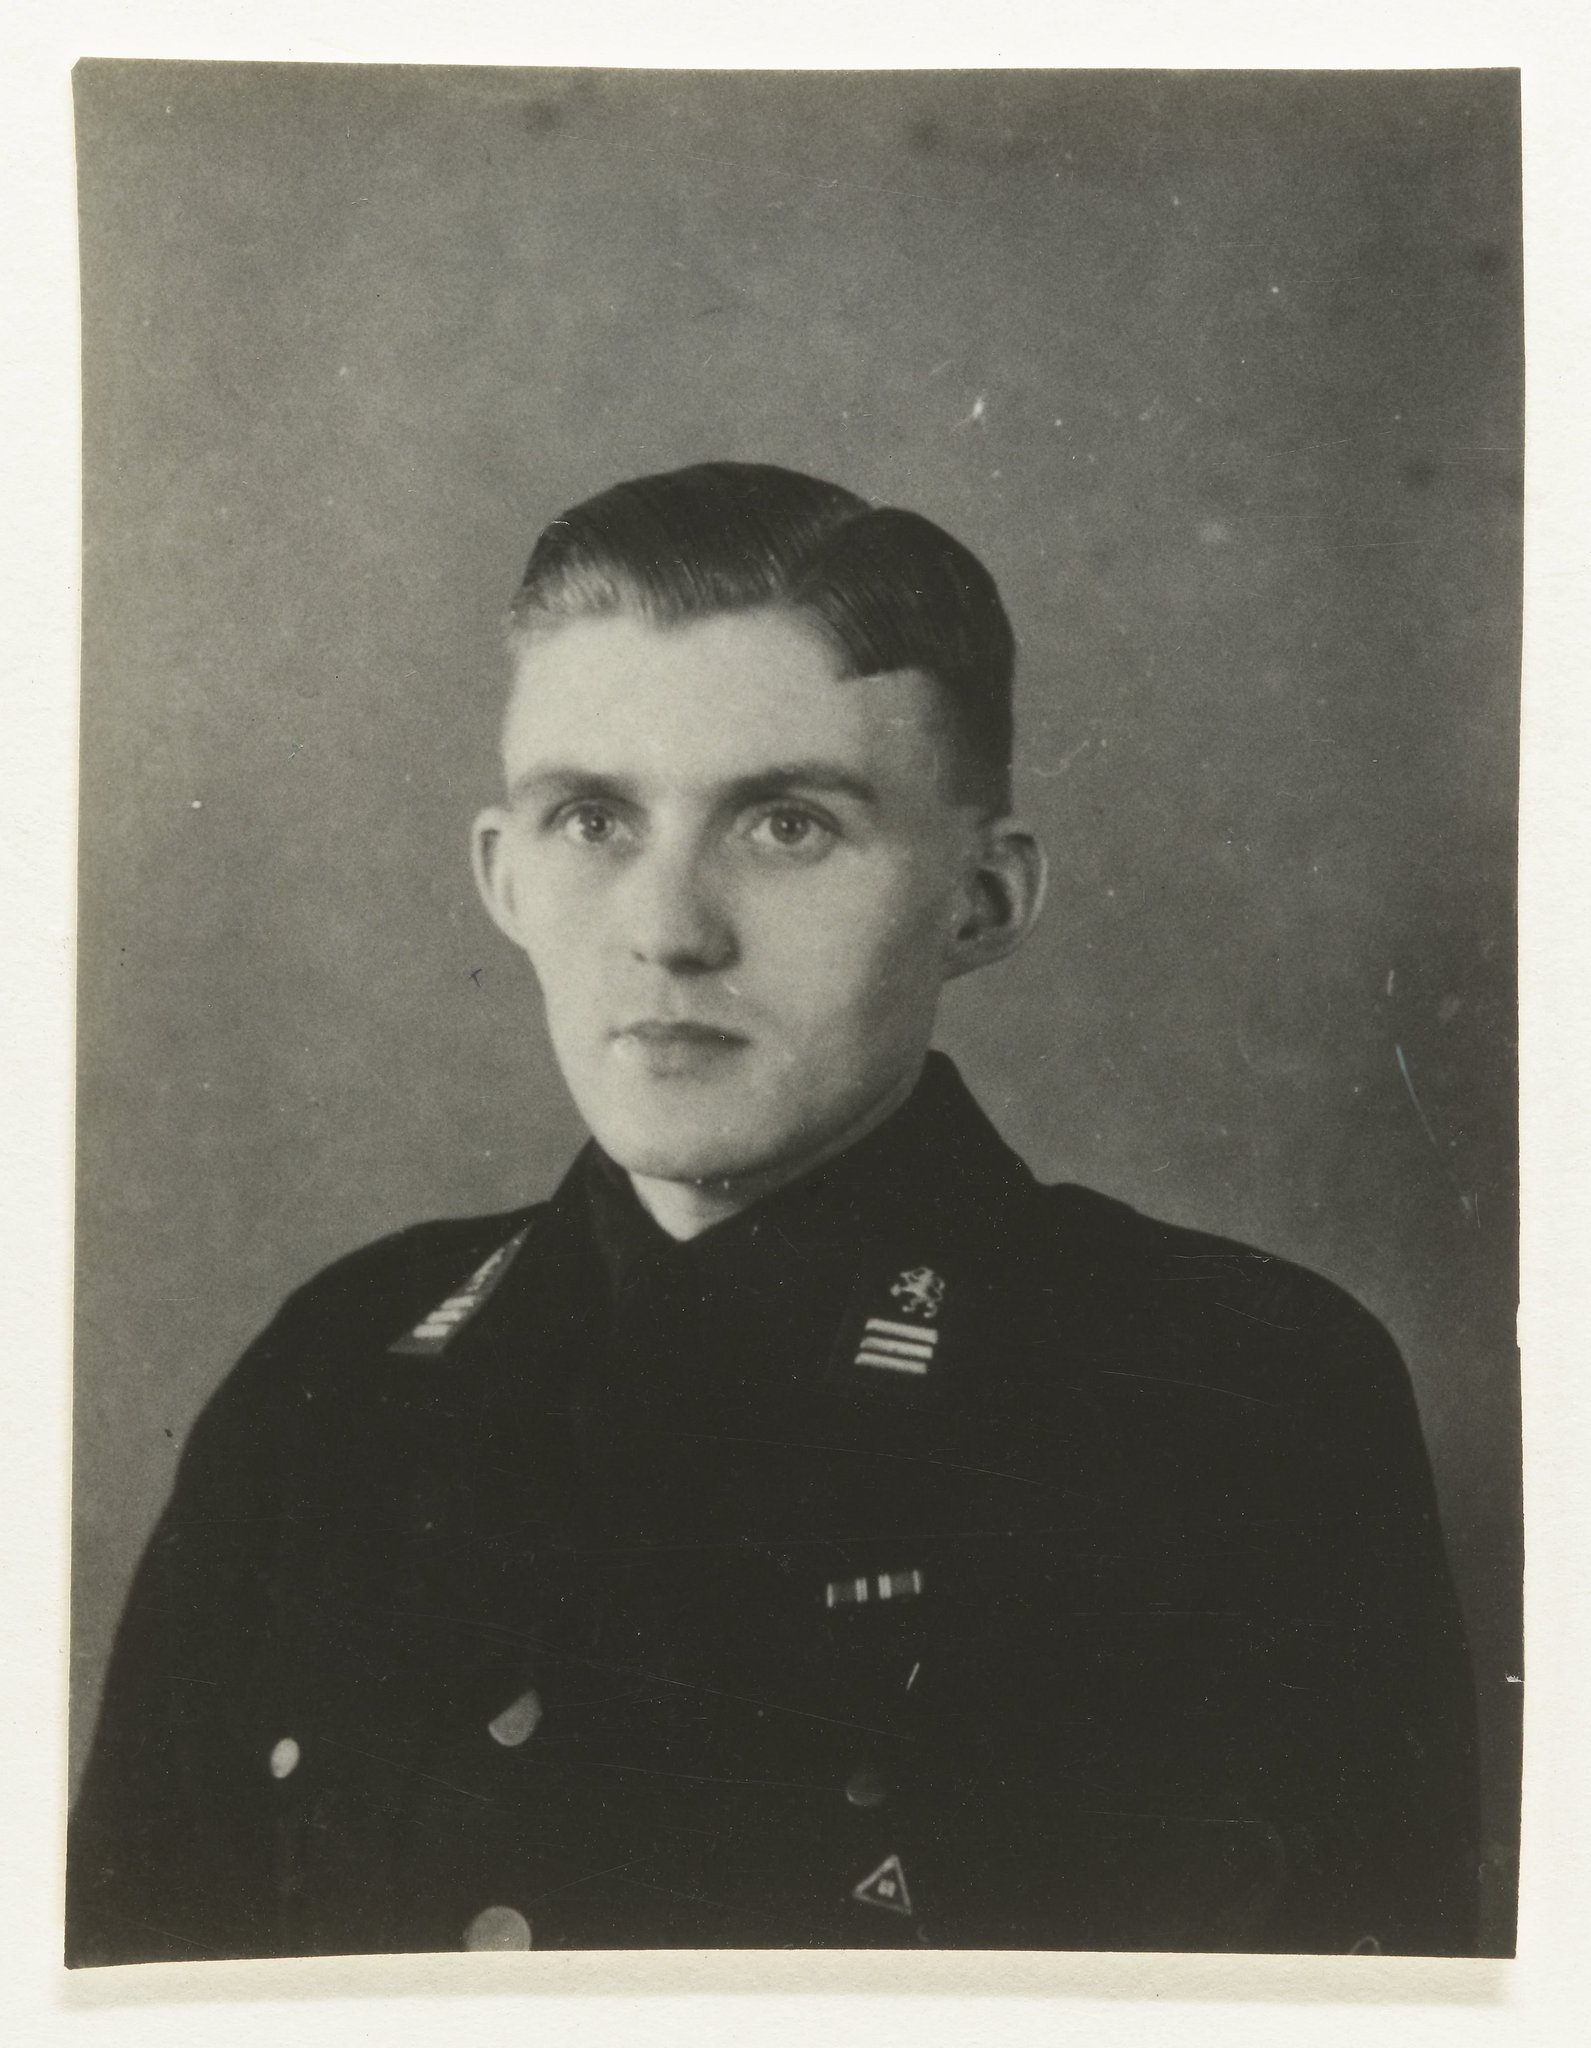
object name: photograph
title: Portret van een lid van de NSB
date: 1940-1944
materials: photographic support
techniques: gelatin silver print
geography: netherlands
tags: anonymous historical person portrayed, netherlands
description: Portret van een lid van de NSB. Op zijn kraag een distinctief met een Nederlandse leeuw en drie strepen: Adjunct hoofd van Dienst (verm.), een administratieve functie. Op zijn uniformjas het NSB symbool. Blootshoofd.